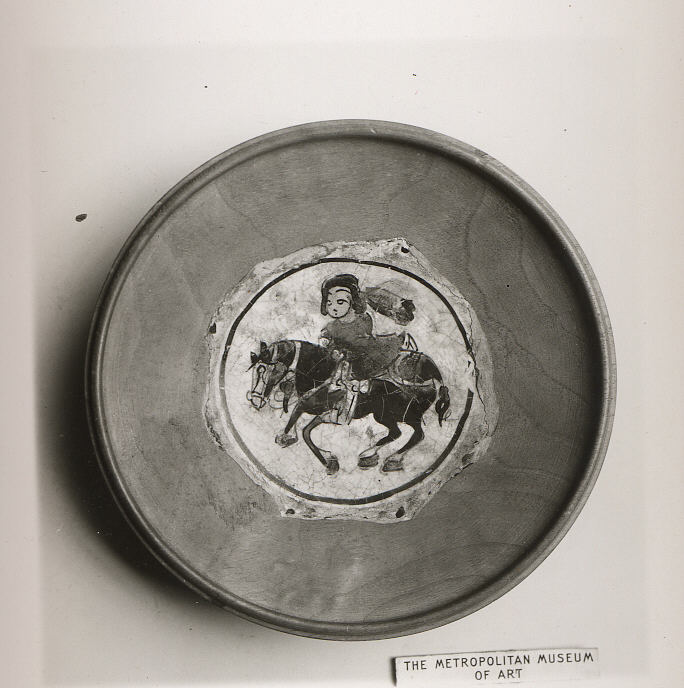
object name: ceramic fragment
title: Fragment of a Bowl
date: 1101-1300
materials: stonepaste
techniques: overglaze, painting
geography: iran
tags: horses